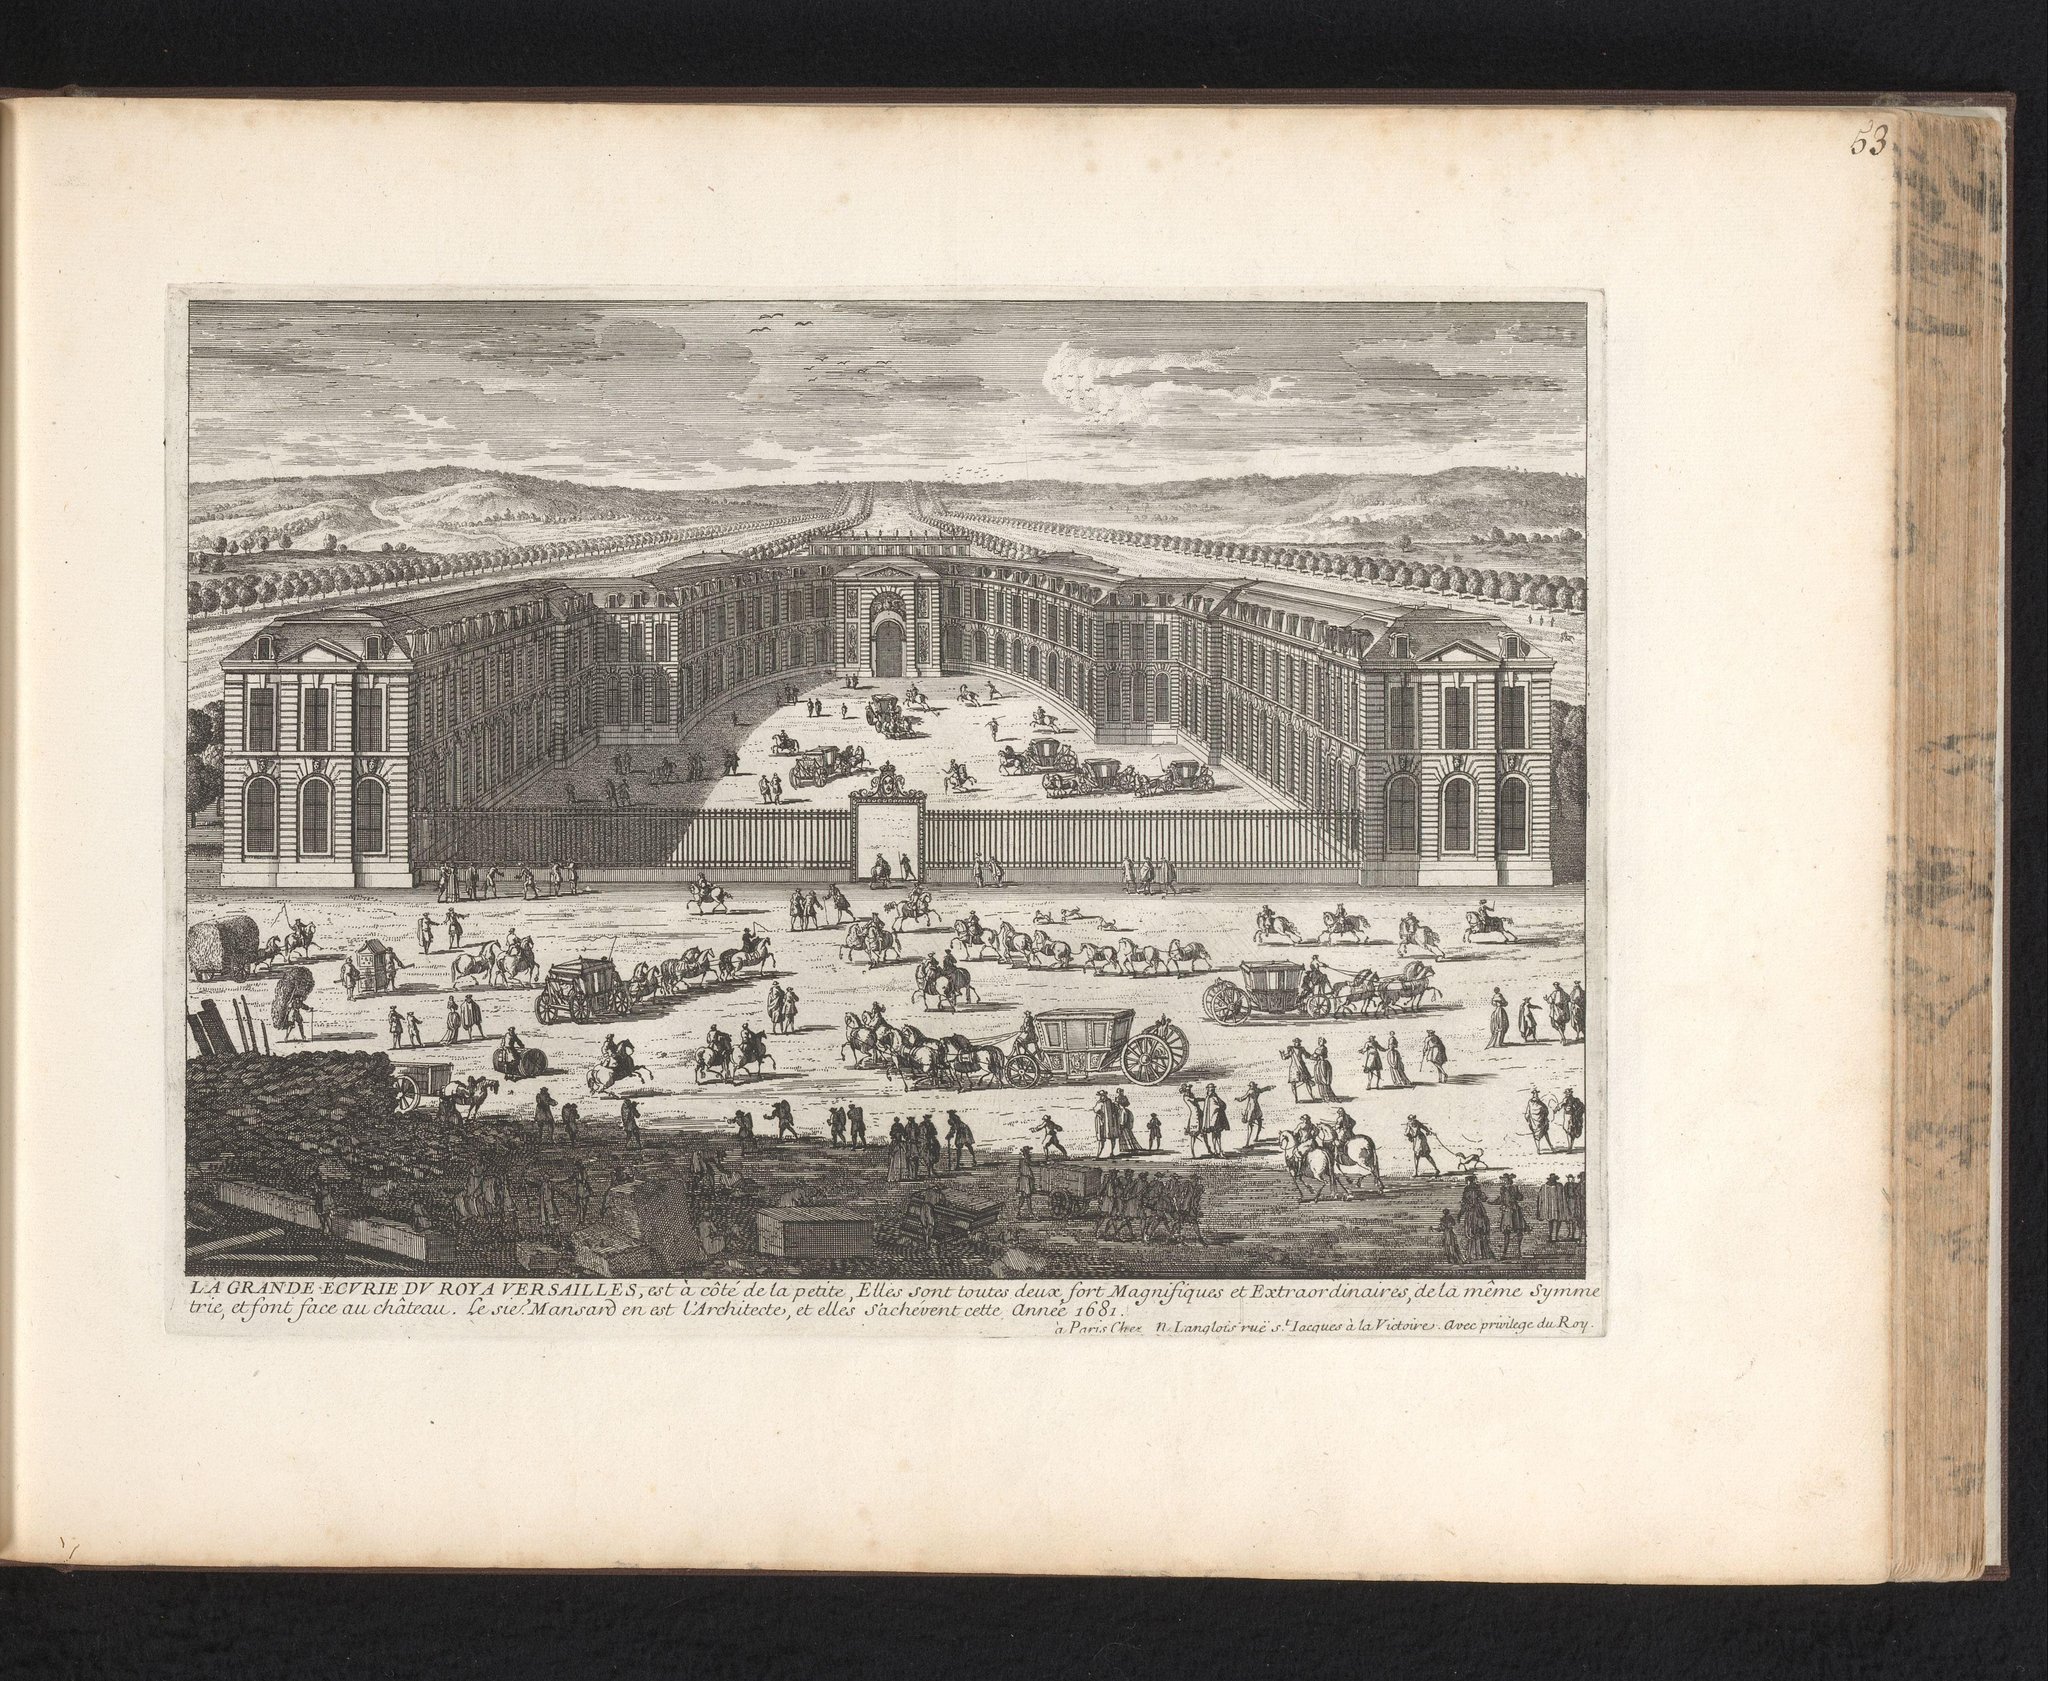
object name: print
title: Gezicht op de stallen van Versailles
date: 1681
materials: paper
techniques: etching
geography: paris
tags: landscape with tower or castle, stall, stable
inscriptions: collector's mark: Lugt 2228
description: Prenten met het signatuur 'Perelle' kunnen zowel door vader Gabriel als door zonen Nicolas en Adam gemaakt zijn. De uitgevers vader en zoon Nicolas Langlois worden allebei vermeld als N. Langlois op hetzelfde adres.